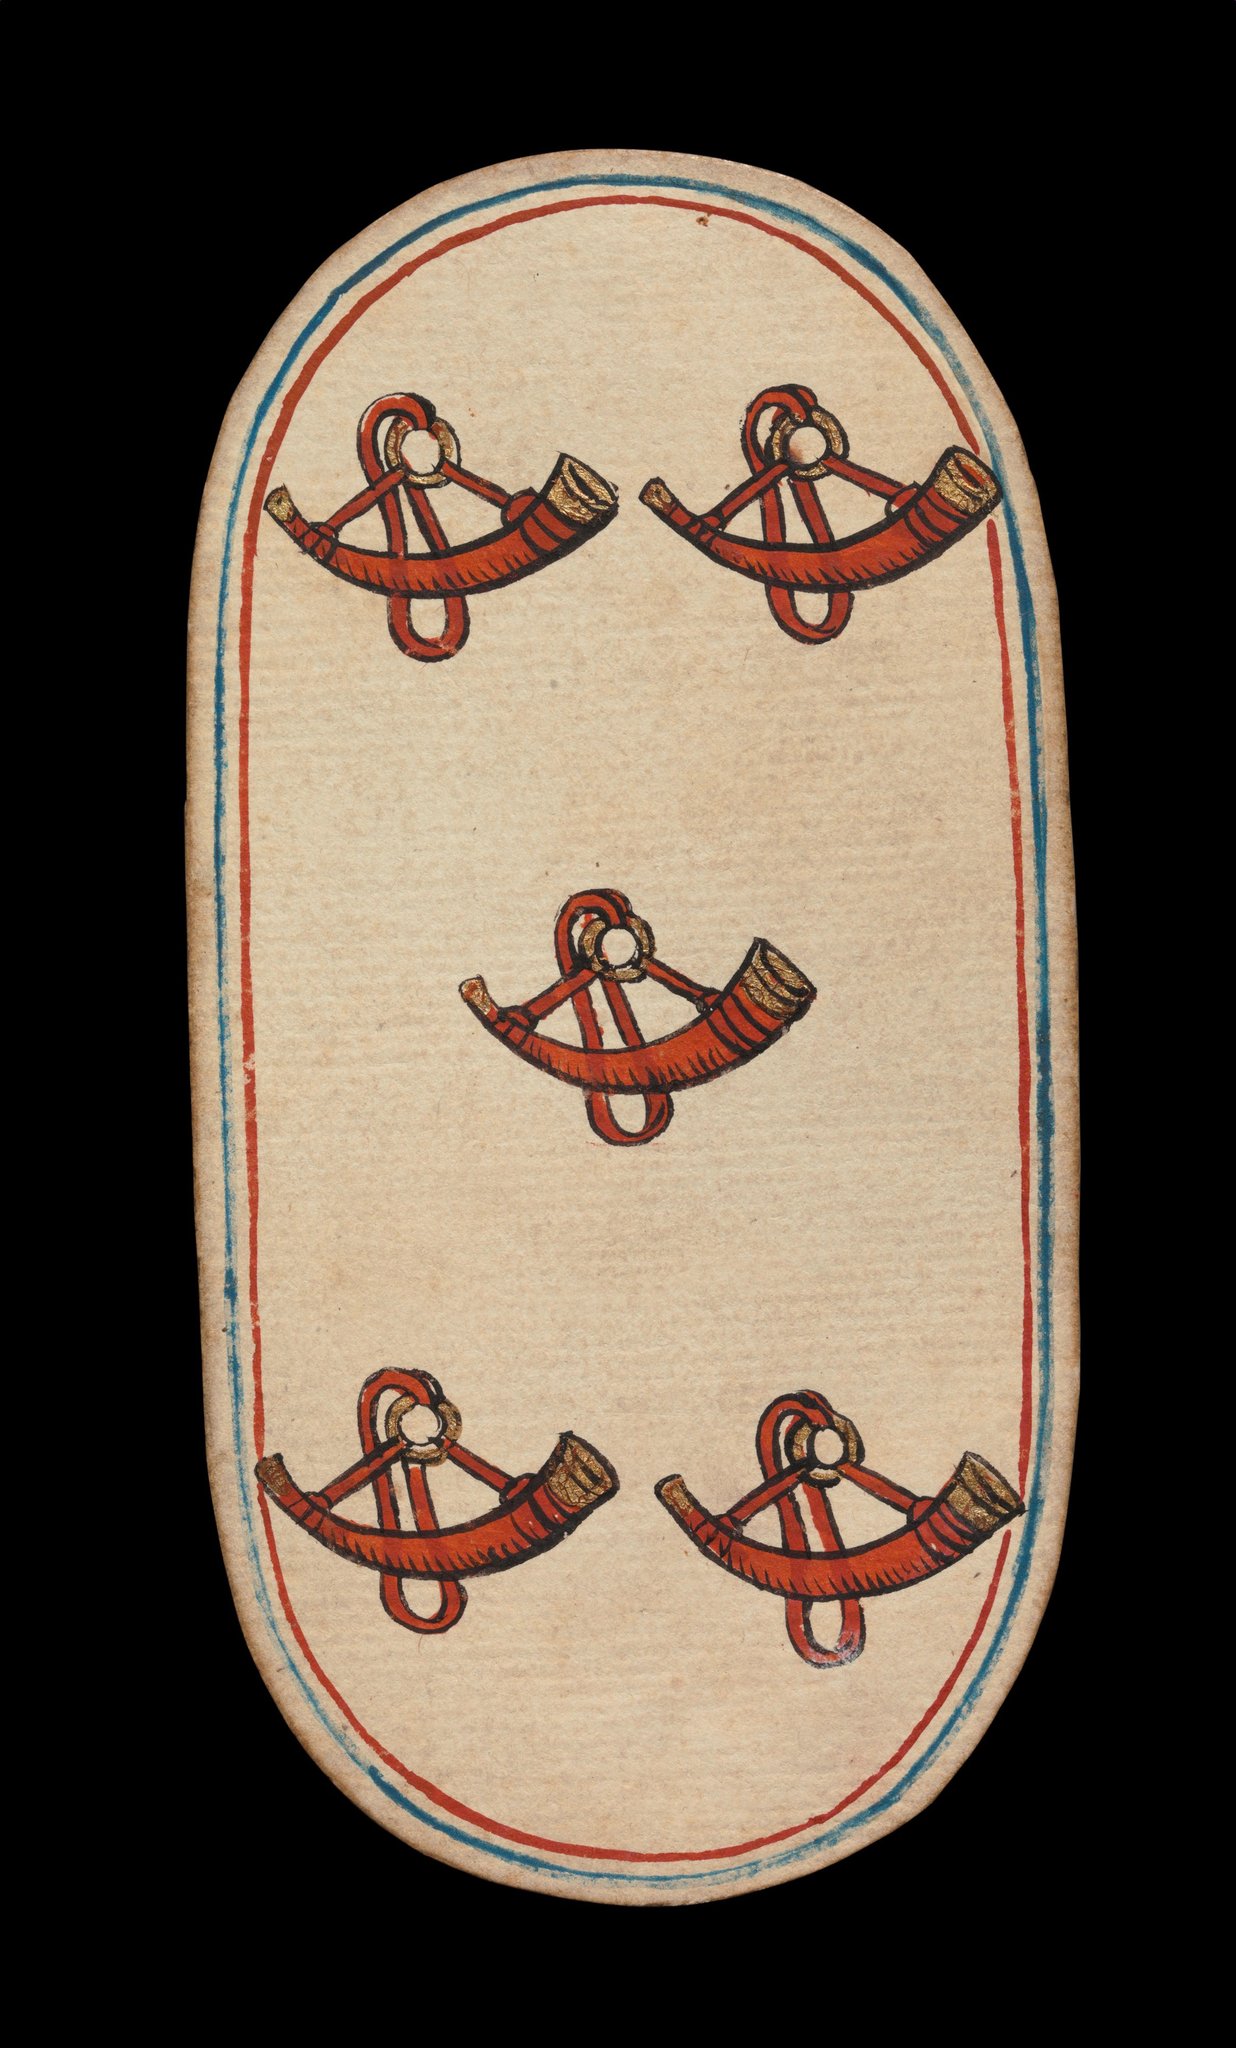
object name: playing card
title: 5 of Horns, from The Cloisters Playing Cards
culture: south netherlandish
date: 1475-1480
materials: glaze, gold, ink, paint, paper, silver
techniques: pen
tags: playing cards,horns,games